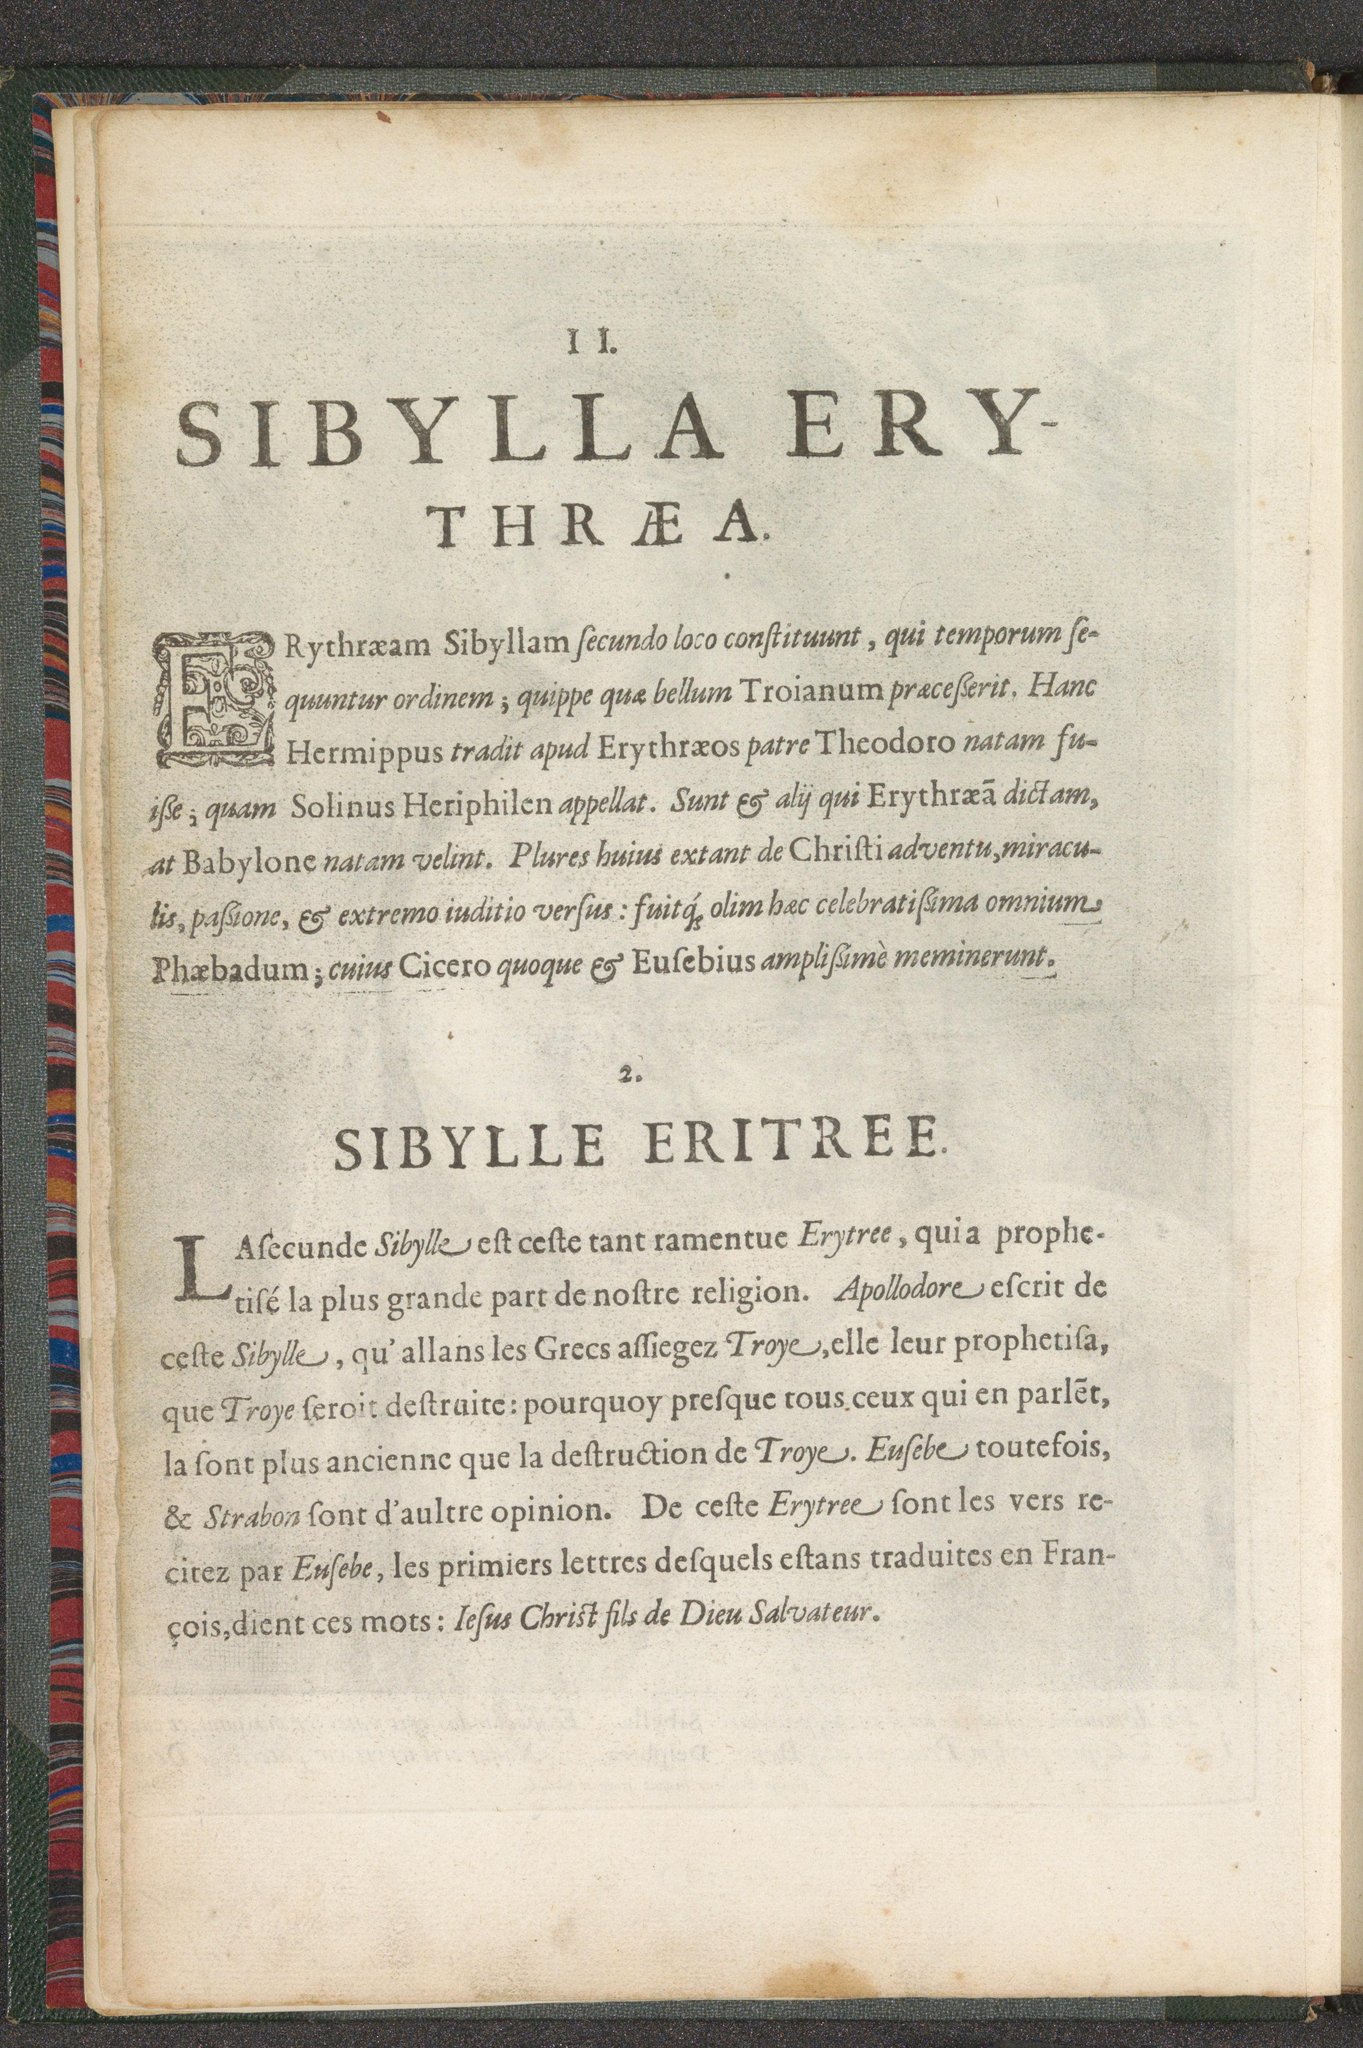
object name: album leaf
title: Tekstblad bij een voorstelling van de Sibille van Erythrae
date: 1615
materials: paper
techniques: letterpress printing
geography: utrecht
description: Een tekst in het Latijn en het Frans over een prent met een voorstelling van de Sibille van Erythrae. Dit blad maakt deel uit van een album.